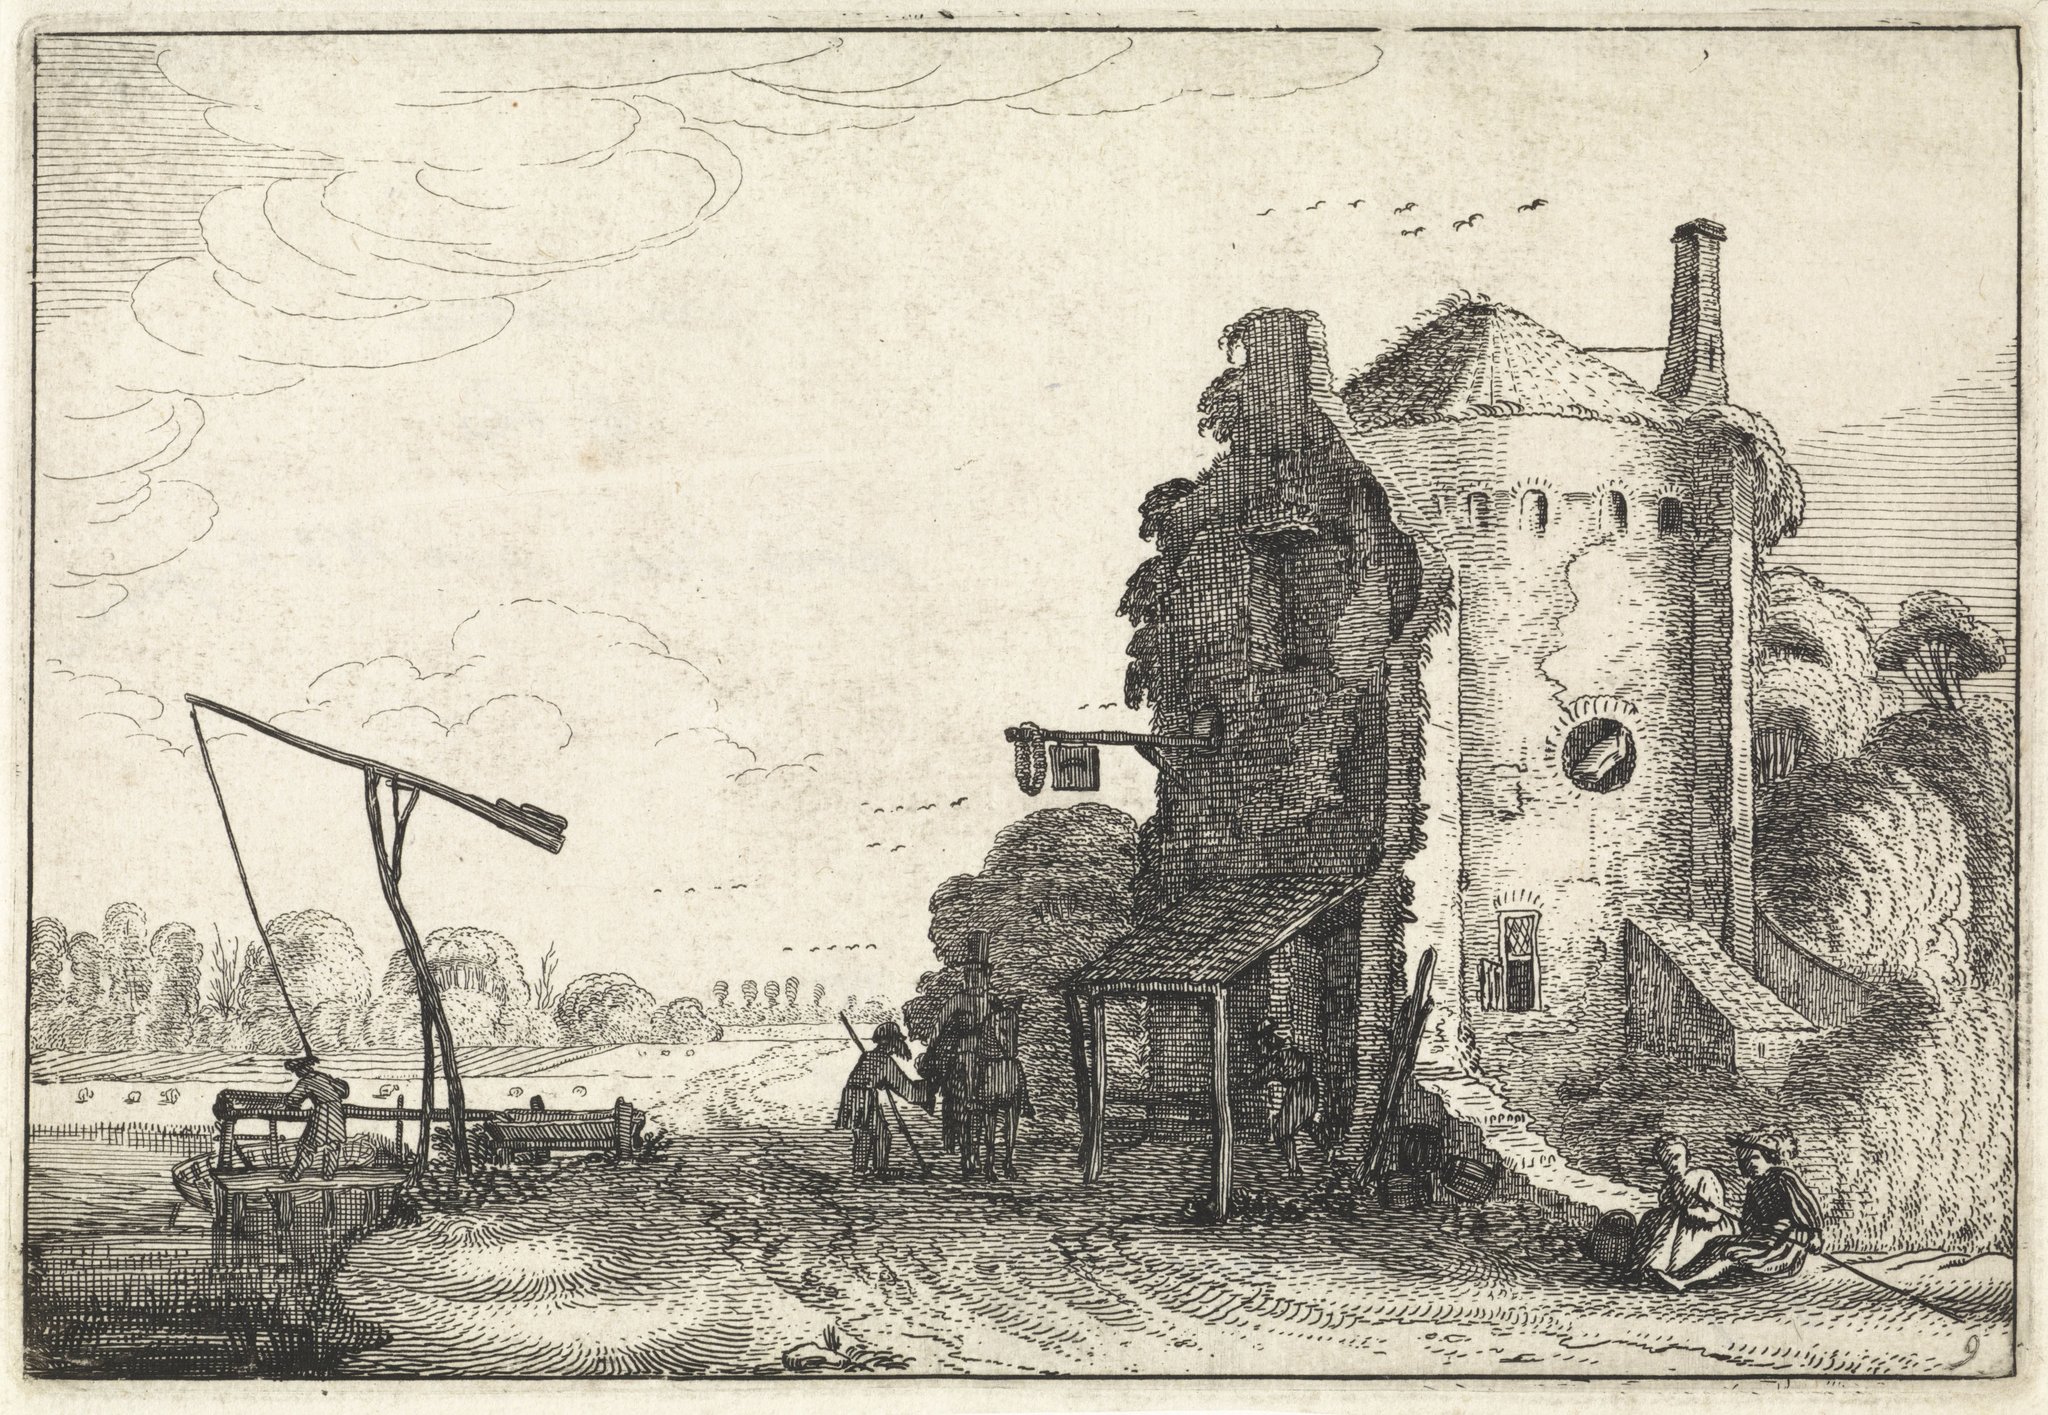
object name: print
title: Amenissimae aliquot requculae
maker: jan van de velde (ii)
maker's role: draughtsman, painter, print maker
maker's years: 1593-1641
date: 1616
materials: paper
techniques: etching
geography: northern netherlands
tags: water-supply (~ public services), landscape with tower or castle, farm or solitary house in landscape, hotel, hostelry, inn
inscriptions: collector's mark: Lugt 964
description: Figuren bij een herberg in een ronde toren in een landschap. Links een man die water uit een rivier haalt. Negende prent van een serie van in totaal 52 prenten met landschappen, verdeeld over twee delen van elk 26 prenten.